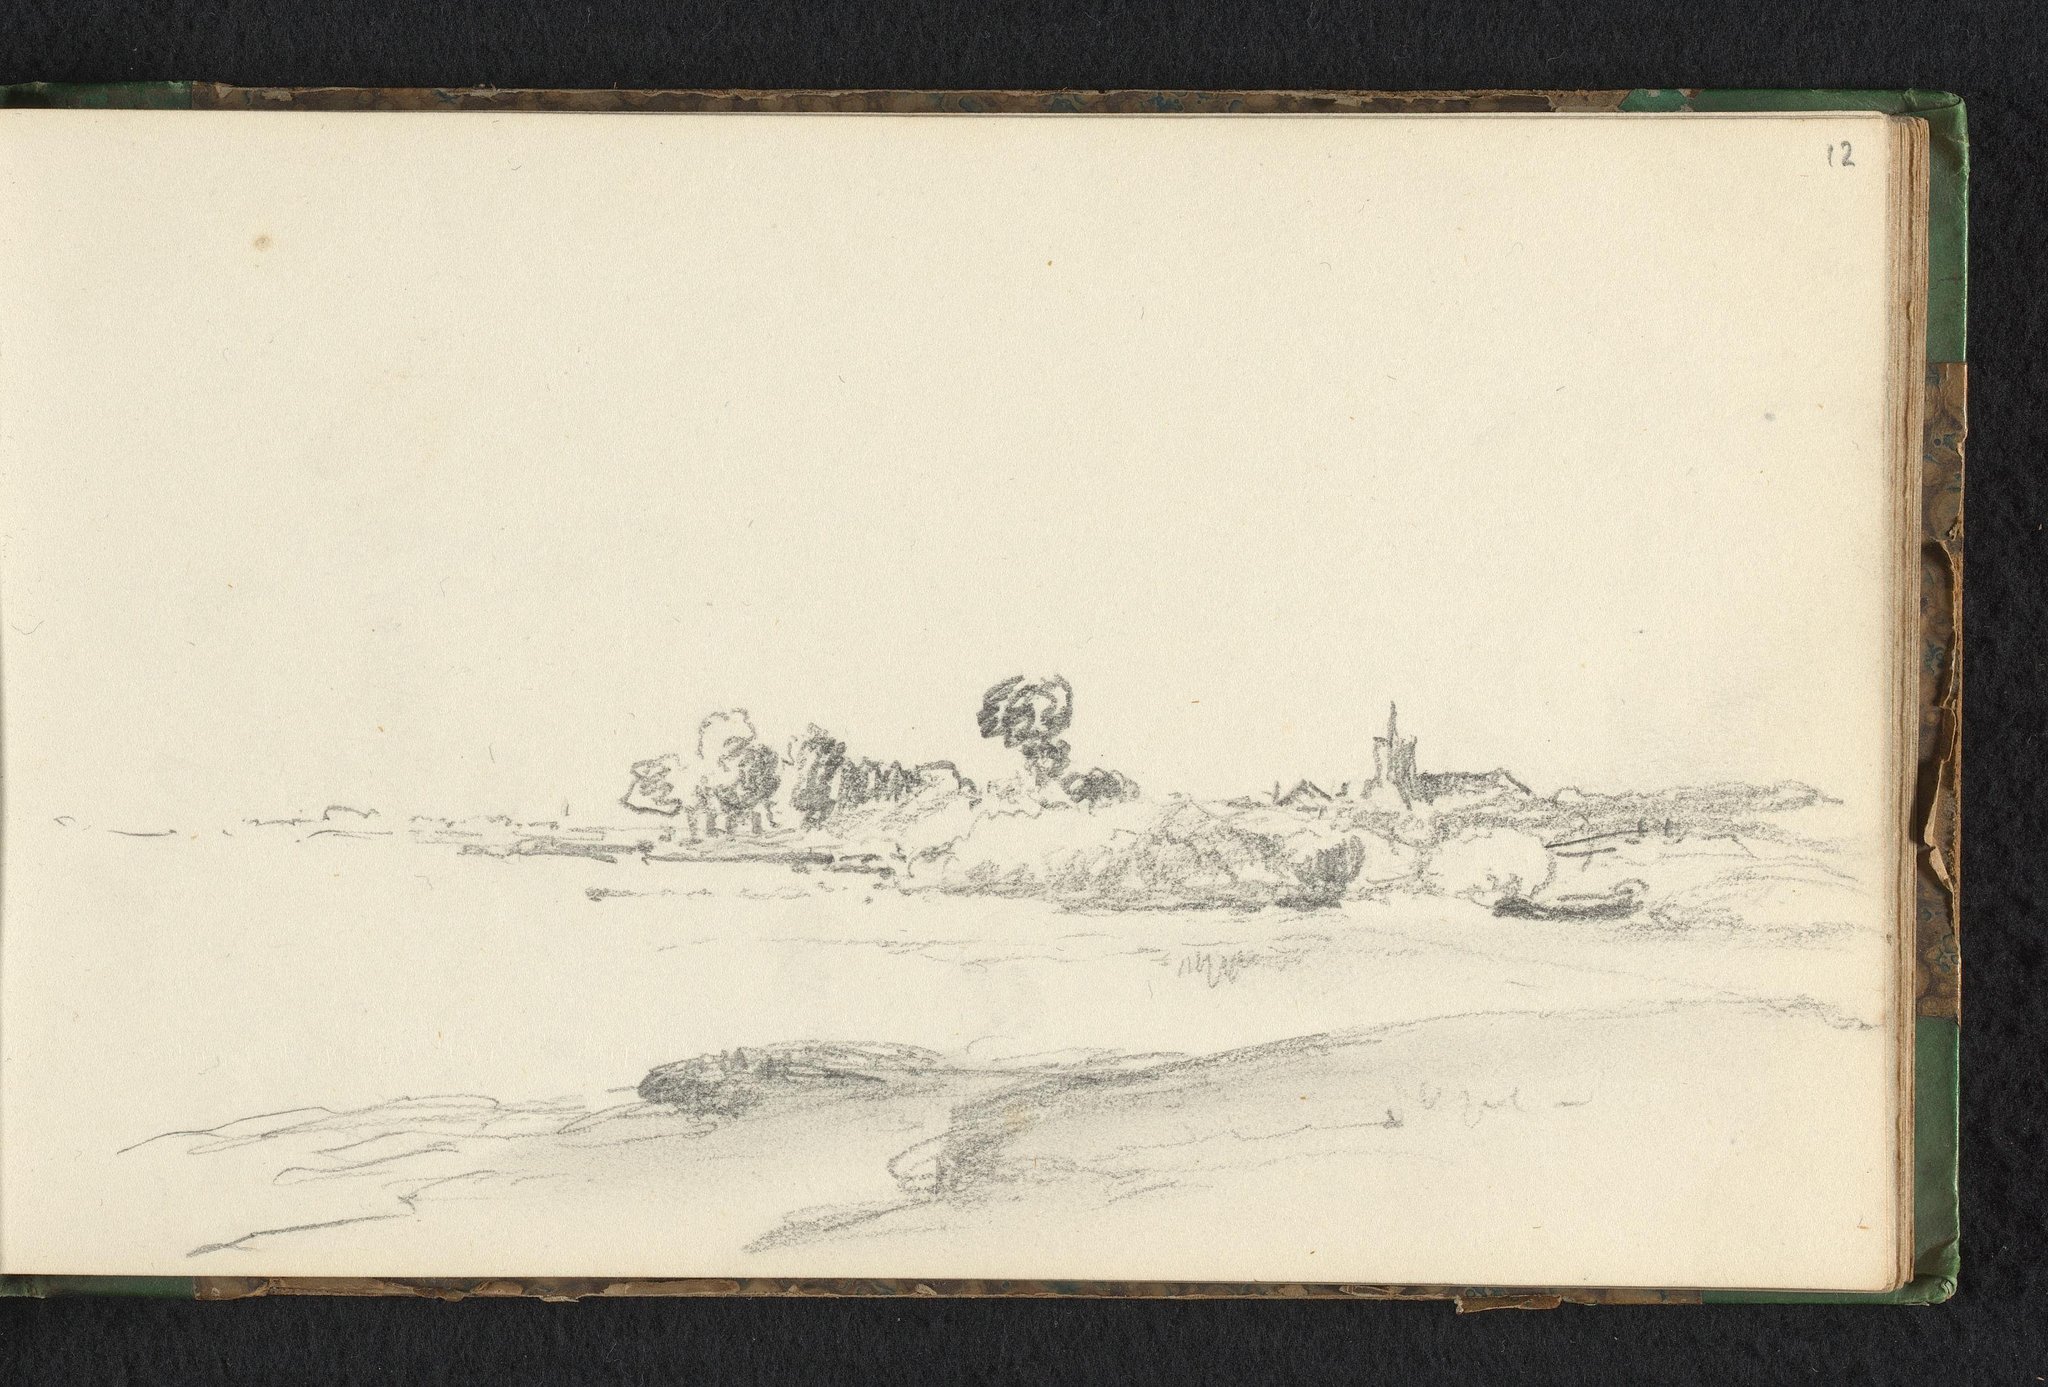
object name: sketchbook leaf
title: Landschap met bomen en kerk aan het water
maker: jan bedijs tom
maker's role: draughtsman, painter, print maker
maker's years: 1813-1894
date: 1823-1894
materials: paper, pencil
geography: the hague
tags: trees, church (exterior), lake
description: Pagina 12 recto uit een schetsboek met 61 bladen.